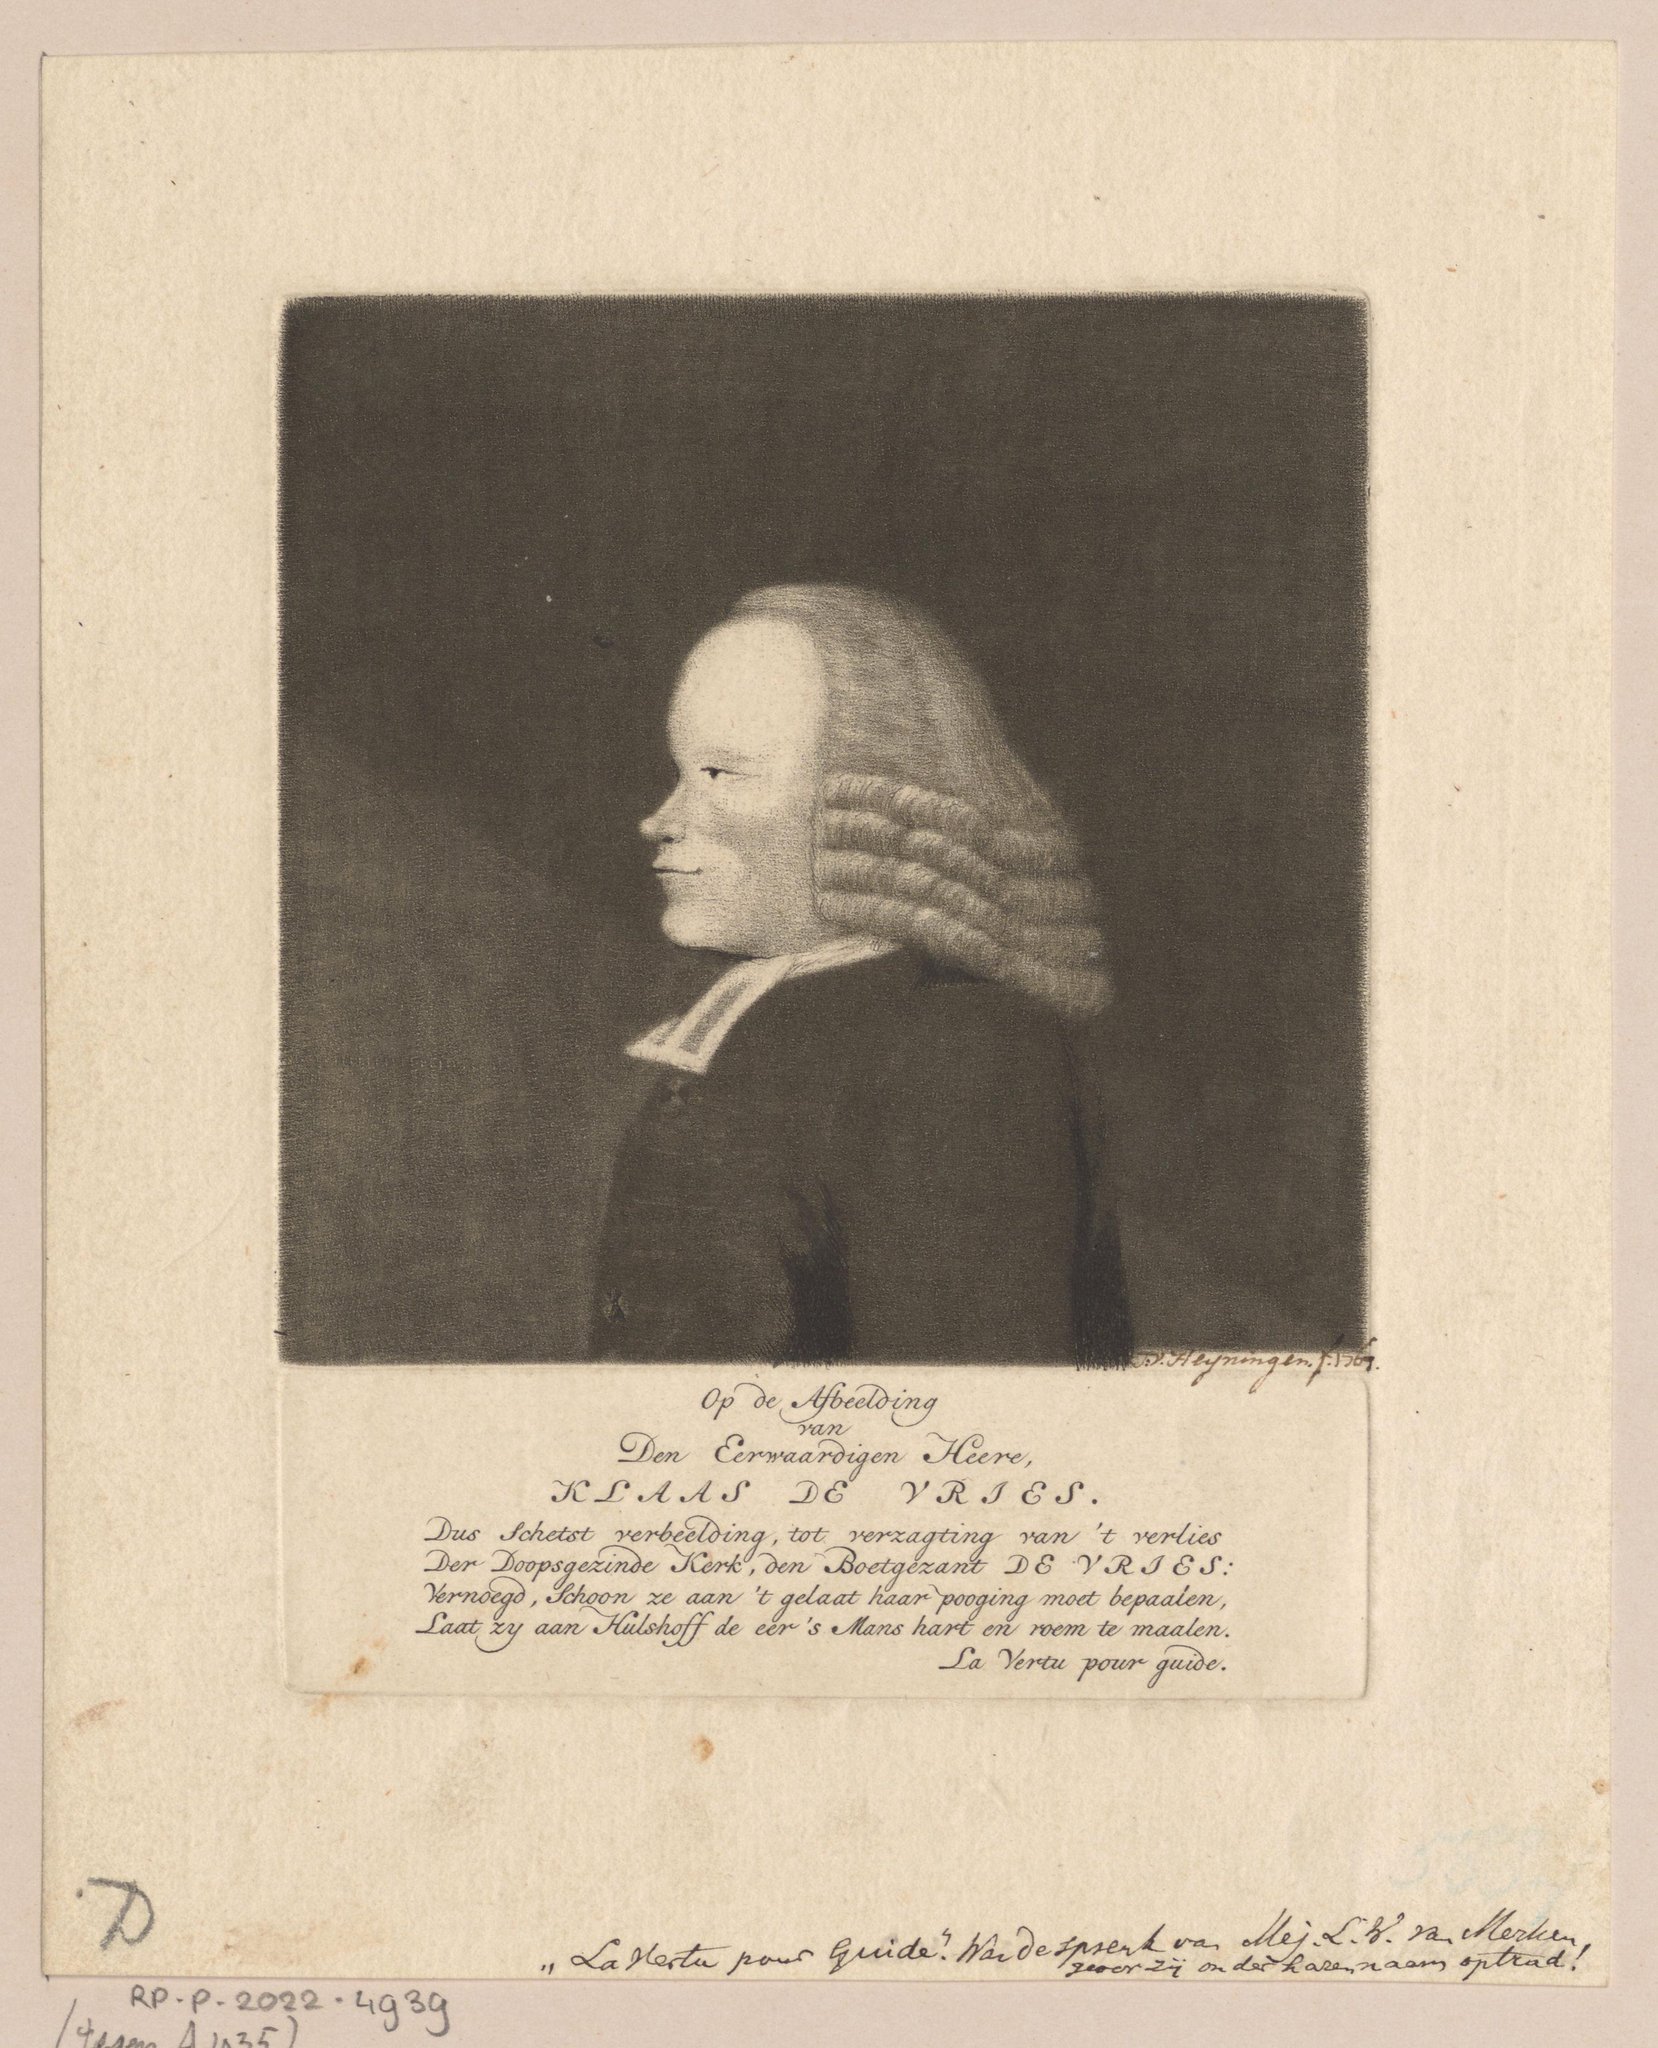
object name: print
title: Portret van Klaas de Vries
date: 1767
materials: paper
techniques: engraving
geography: low countries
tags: theologian, historical persons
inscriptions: inscription: ‘"La verte pour guide'. Was de spreuk van mej L.W. van Merken / voor zij onder haren naam optrad!’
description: Met vierregelig vers in het Nederlands, gedrukt van een aparte plaat.